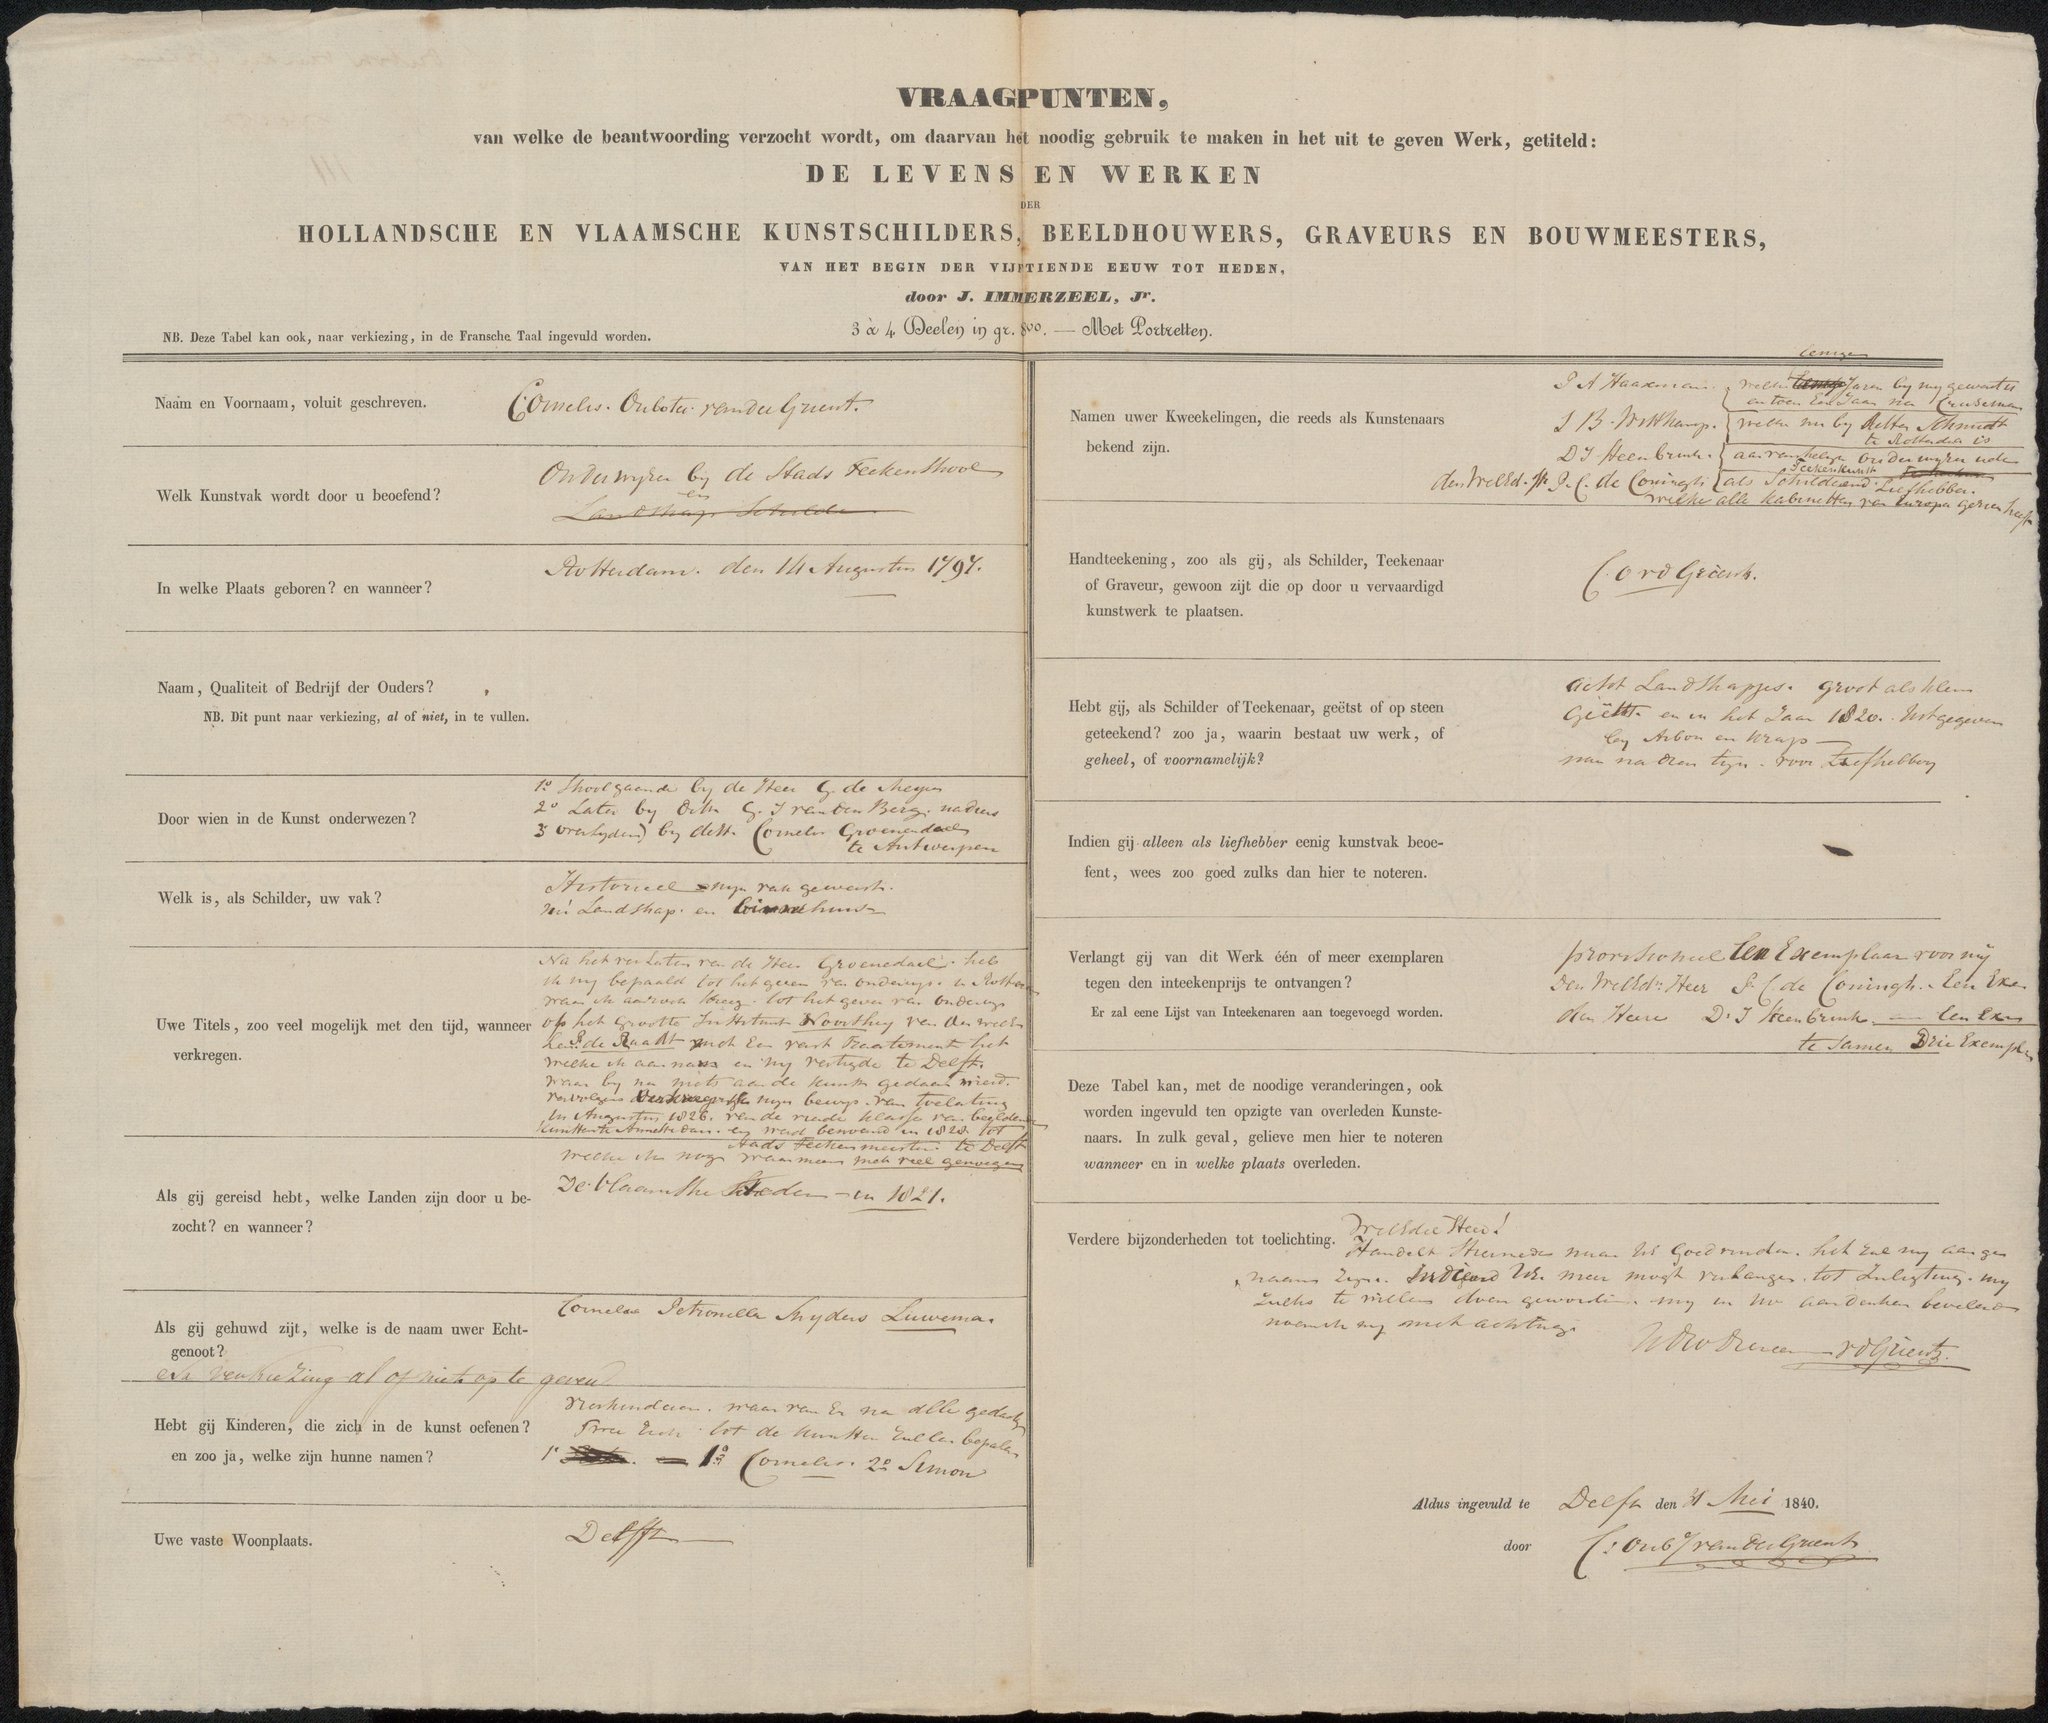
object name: manuscript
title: Enquêteformulier ingevuld door Cornelis Ouboter van der Griendt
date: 1840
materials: ink, paper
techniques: pen, printing, writing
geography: delft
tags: rotterdam, overschie, print maker, cornelis ouboter van der griendt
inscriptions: inscription: ‘Vraagpunten,/ van welke de beantwoording verzocht wordt, om daarvan het noodig gebruik te maken in het uit te geven Werk, getiteld: De levens en werken/ der Hollandsche en Vlaamsche kunstschilders, beeldhouwers,/ graveurs en bouwmeesters, van het begin der vijftiende eeuw tot heden/ door J. Immerzeel, Jr.’, watermark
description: Opgenomen in: Immerzeel, J. Jr., De levens en werken der Hollandsche en Vlaamsche kunstschilders, beeldhouwers, graveurs en bouwmeesters, van het begin der vijftiende eeuw tot heden, Amsterdam: J.C. van Kesteren, 1842-1843.